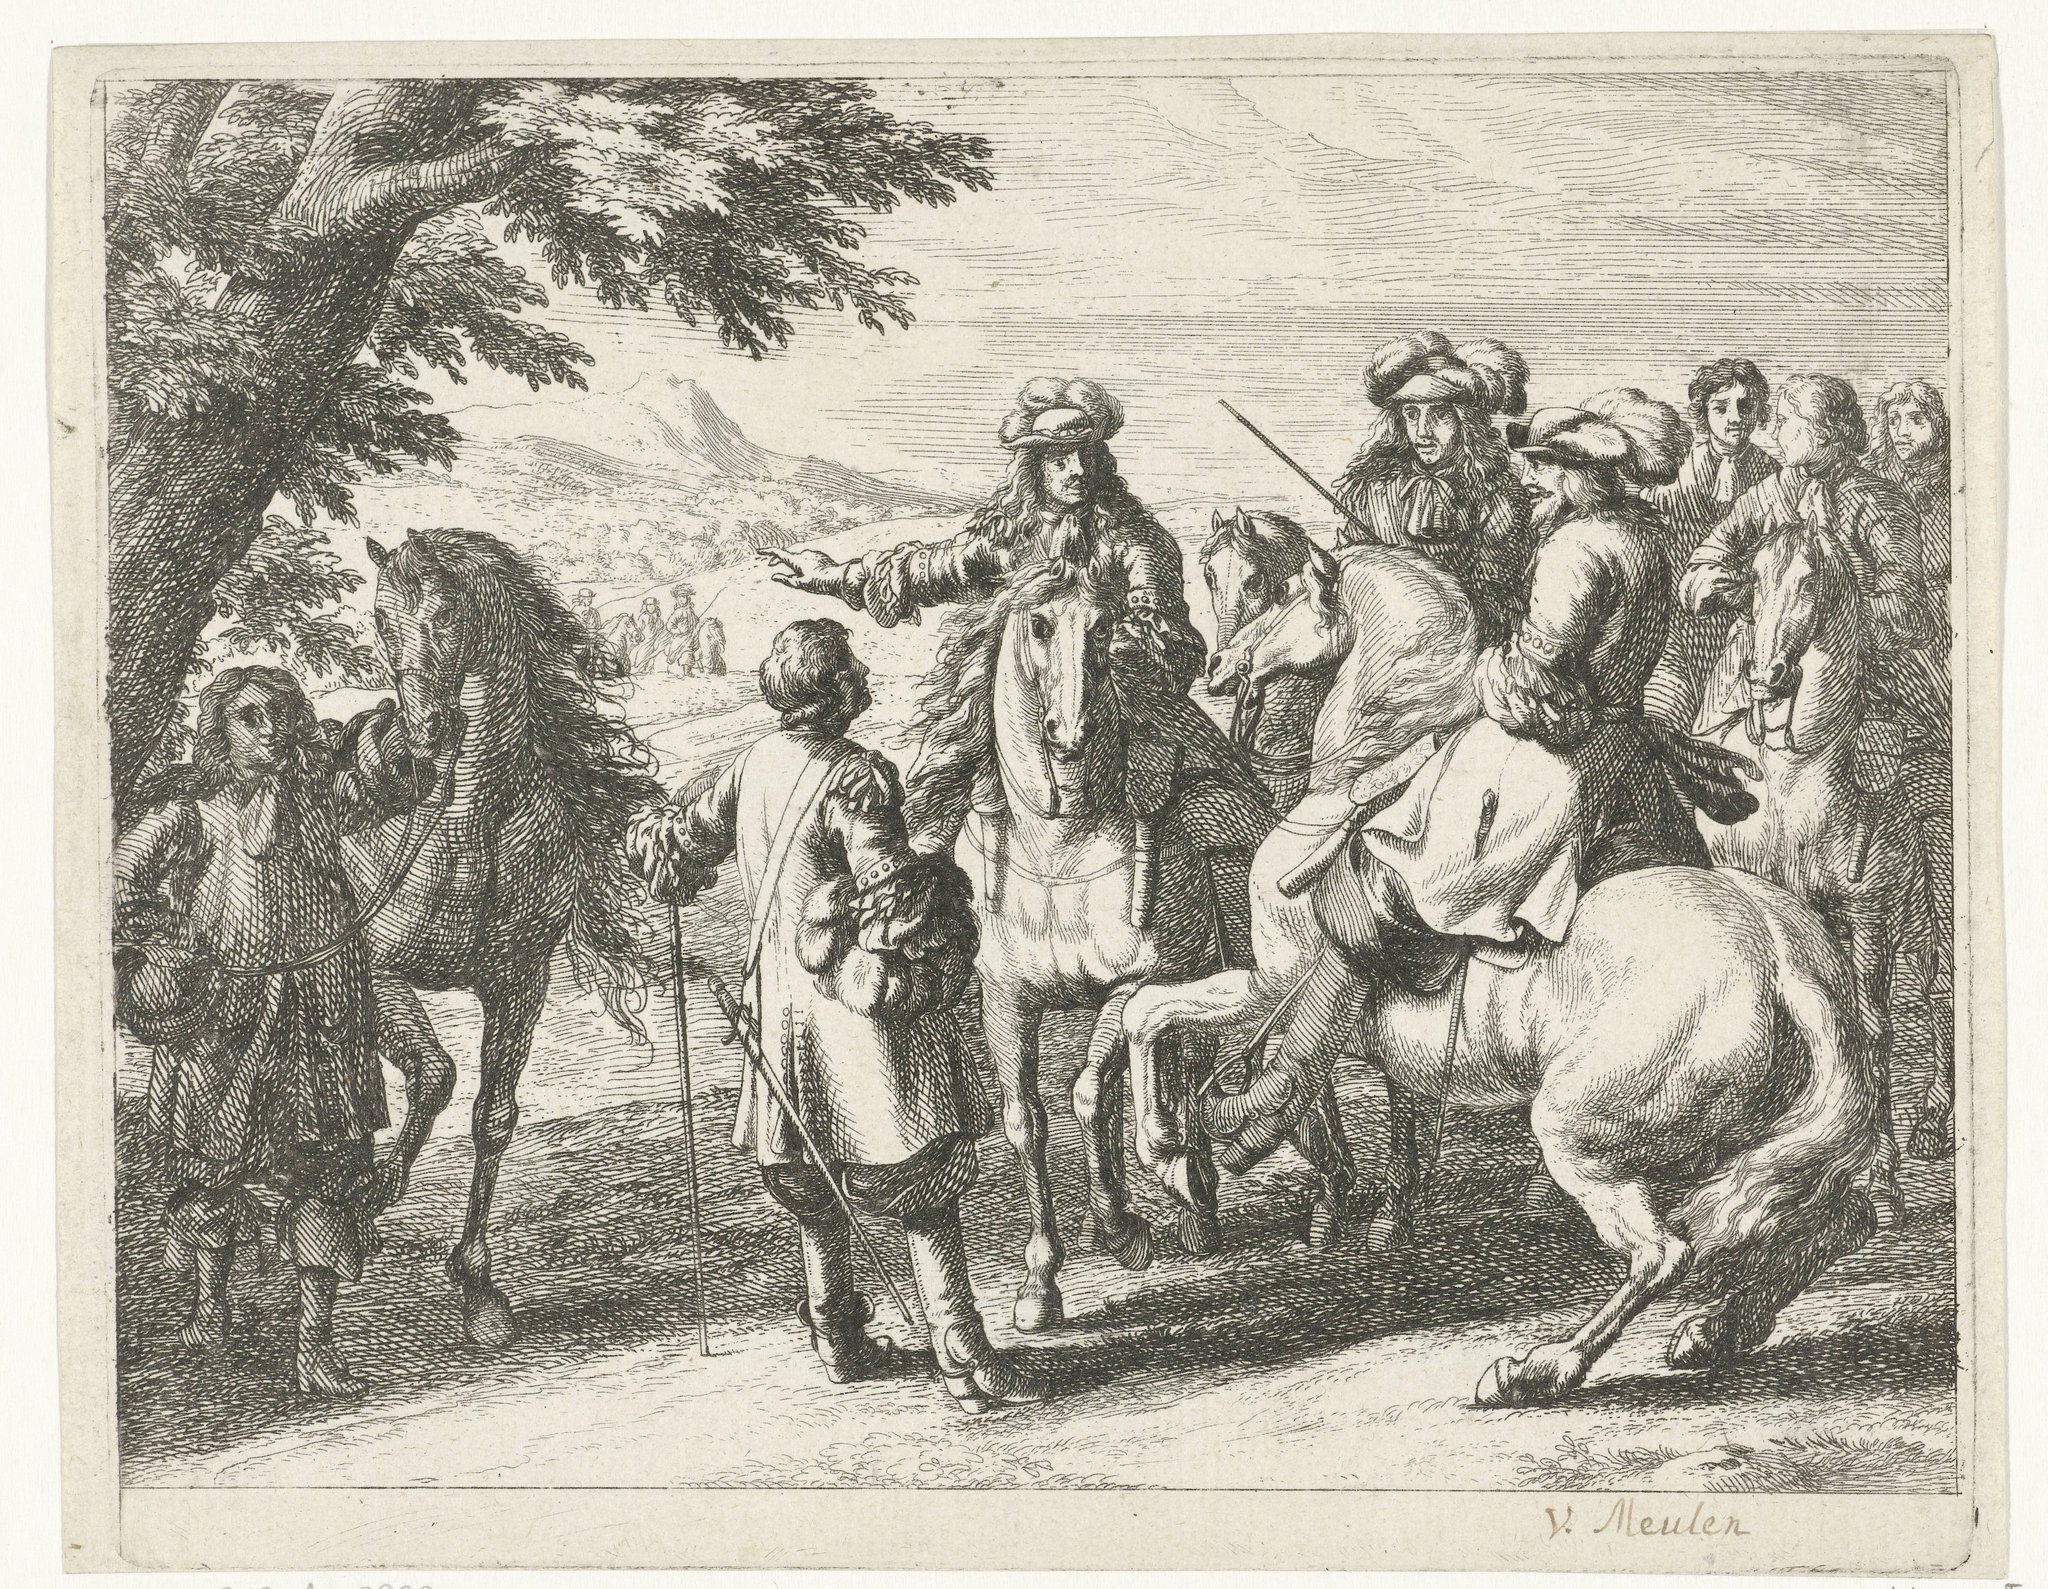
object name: print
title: Aanvoerders te paard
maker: jan van huchtenburg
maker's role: draughtsman, painter, print maker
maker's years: 1647-1733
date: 1674-1733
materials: paper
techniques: engraving, etching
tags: landscapes (+ landscape with figures, staffage), war and peace (+ cavalry, horsemen)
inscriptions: inscription: ‘V. Meulen’, collector's mark: Lugt 2228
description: Een overleg tussen drie mannen te paard en één op de grond staande man op de voorgrond in een landschap. Links houdt een man een paard bij de teugels.